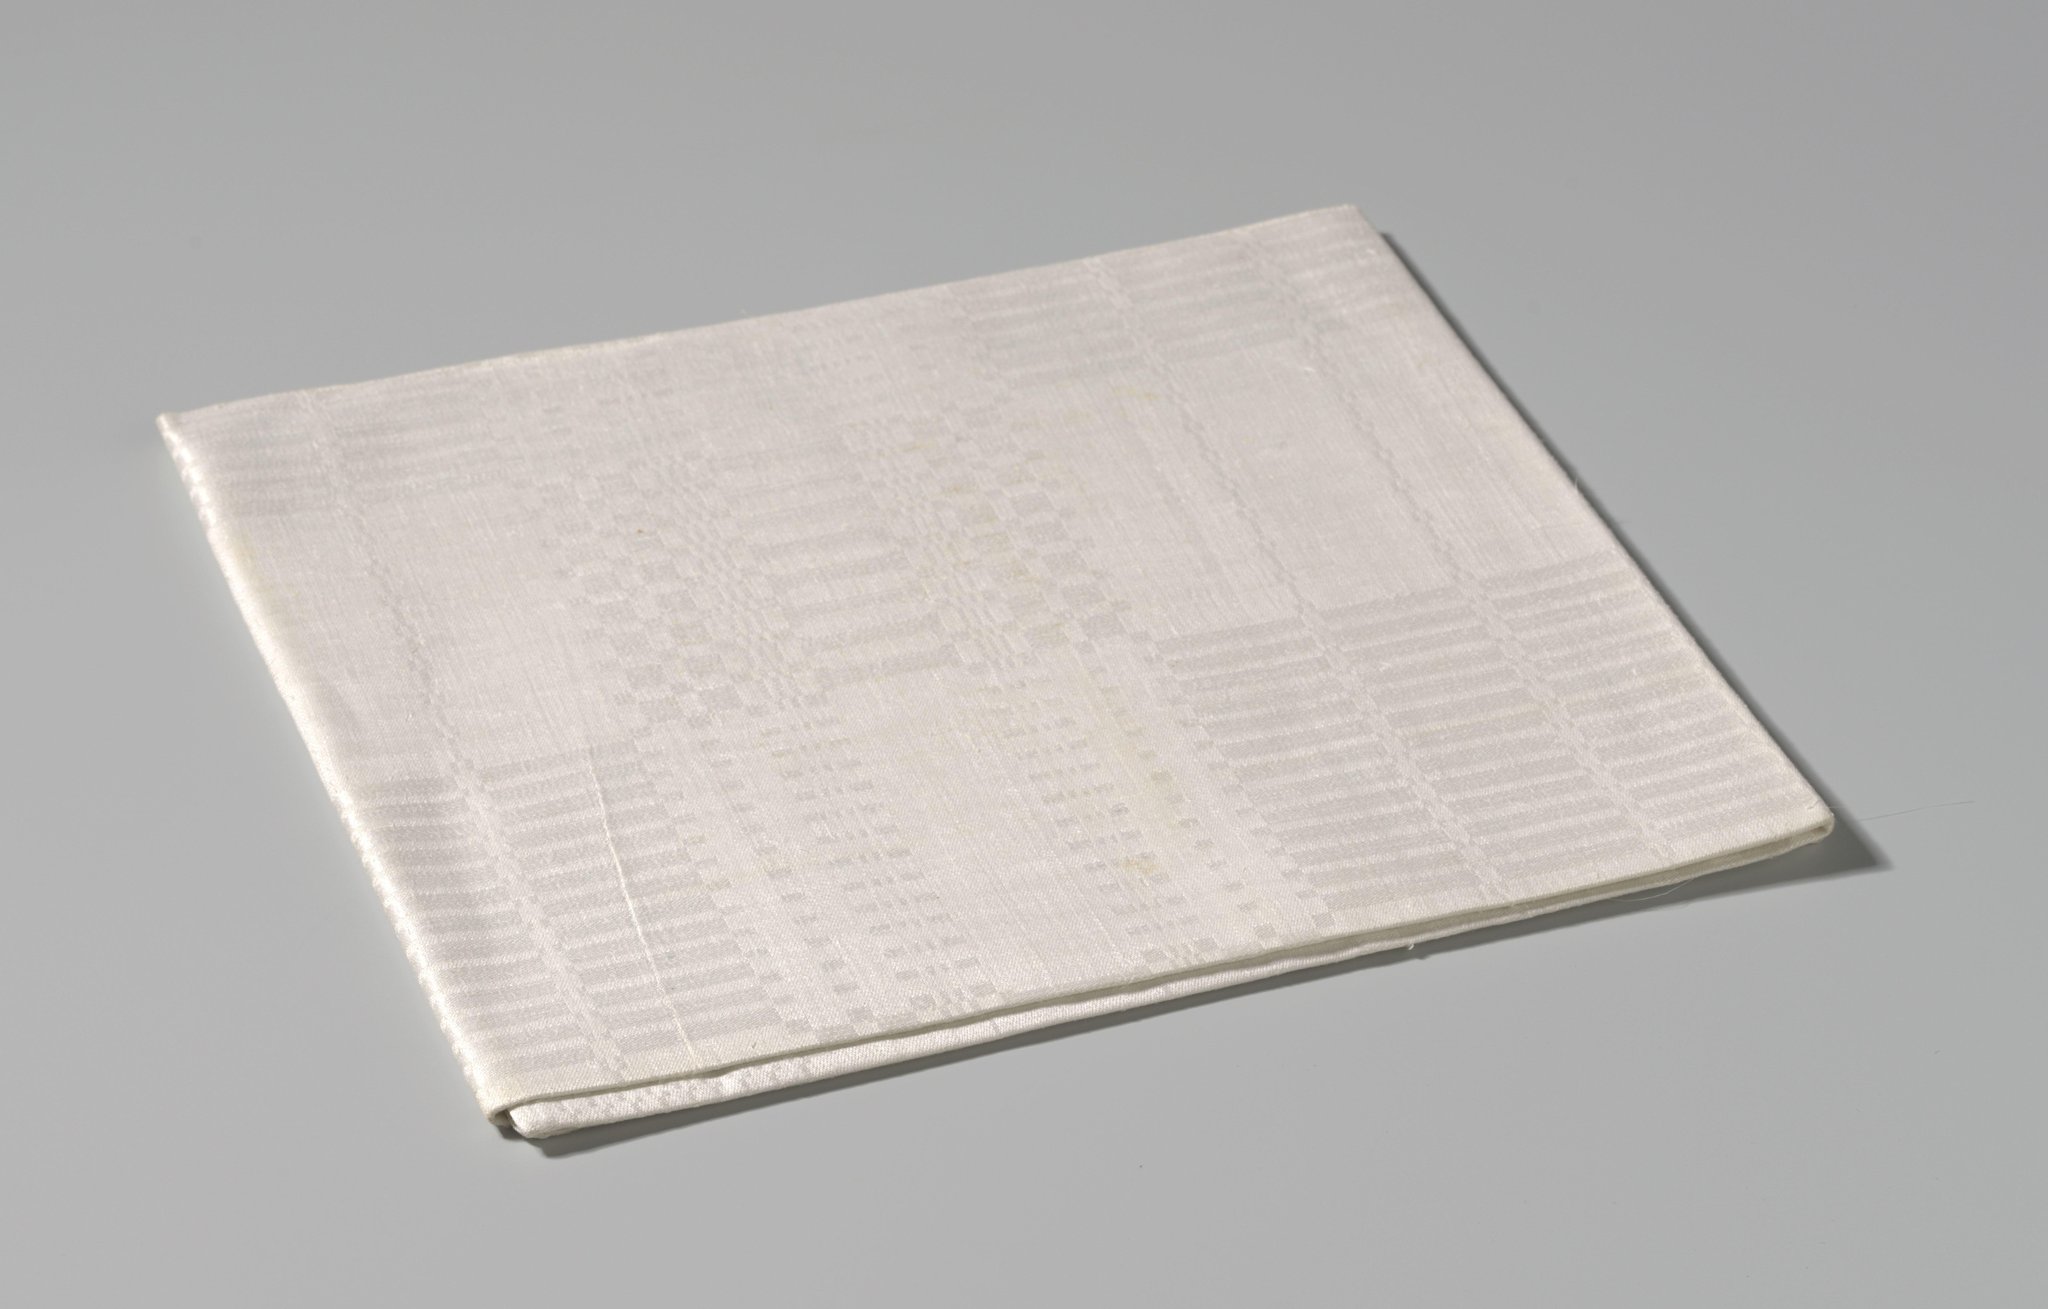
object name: napkin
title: Servet van linnen met pellenpatroon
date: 1785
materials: linen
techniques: peeled fabric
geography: northern netherlands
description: wit linnen servet met pellen patroon, merk SW 34 en 1785